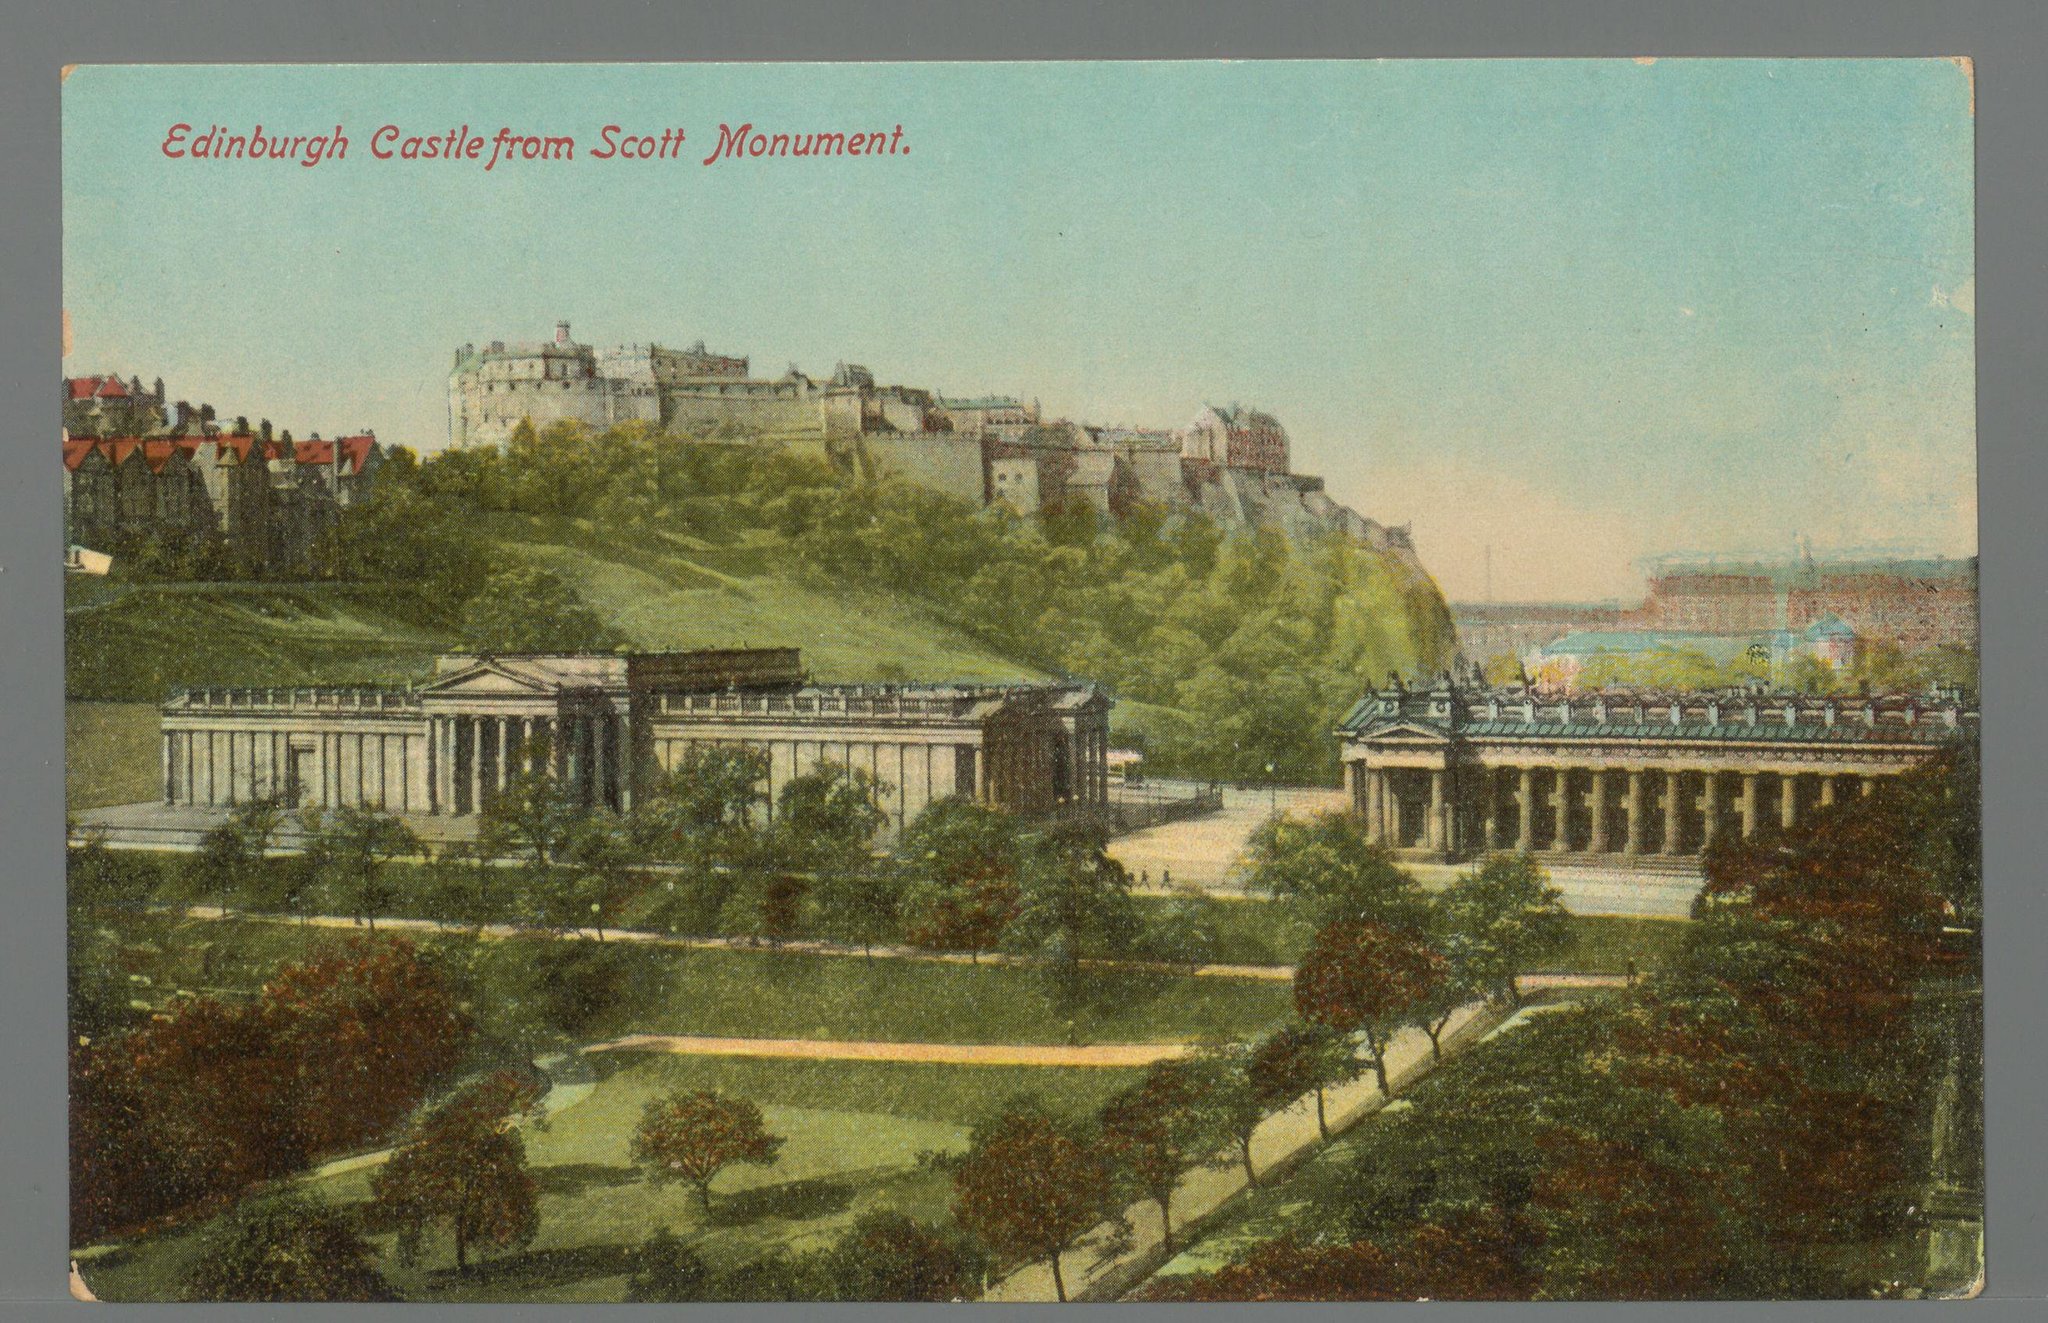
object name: photomechanical print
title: Reliable Series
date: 1902-1930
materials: cardboard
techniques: lithograph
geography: edinburgh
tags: castle